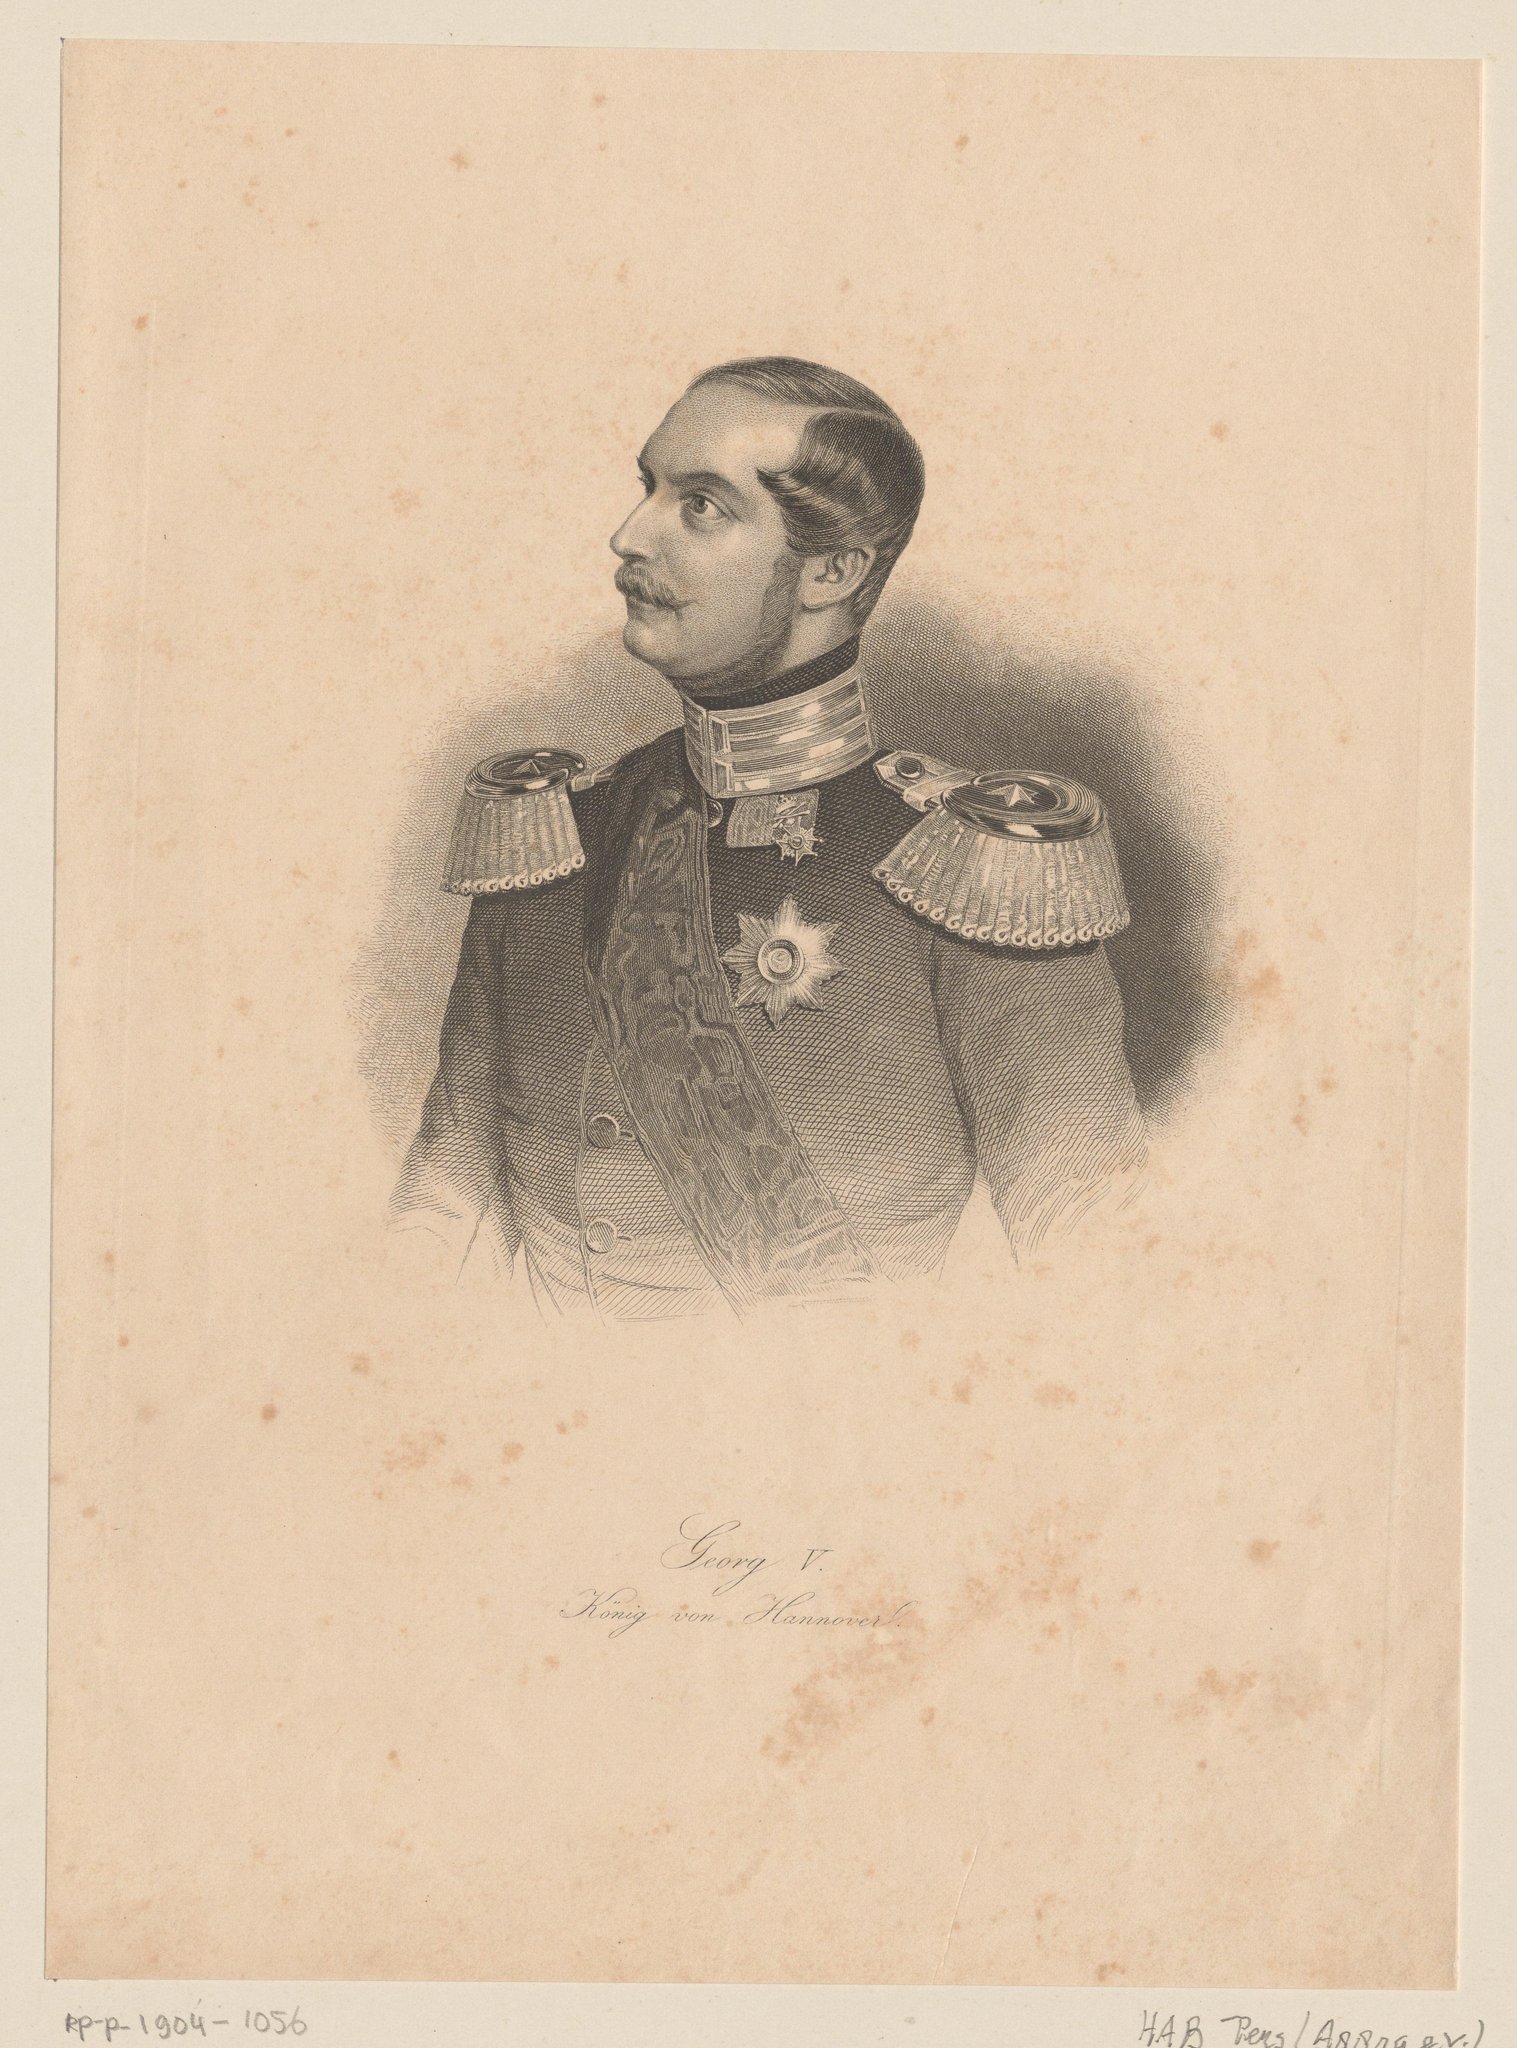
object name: print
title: Portret van George V, koning van Hannover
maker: Anonymous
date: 1851-1890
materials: paper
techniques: lithograph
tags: historical persons, king